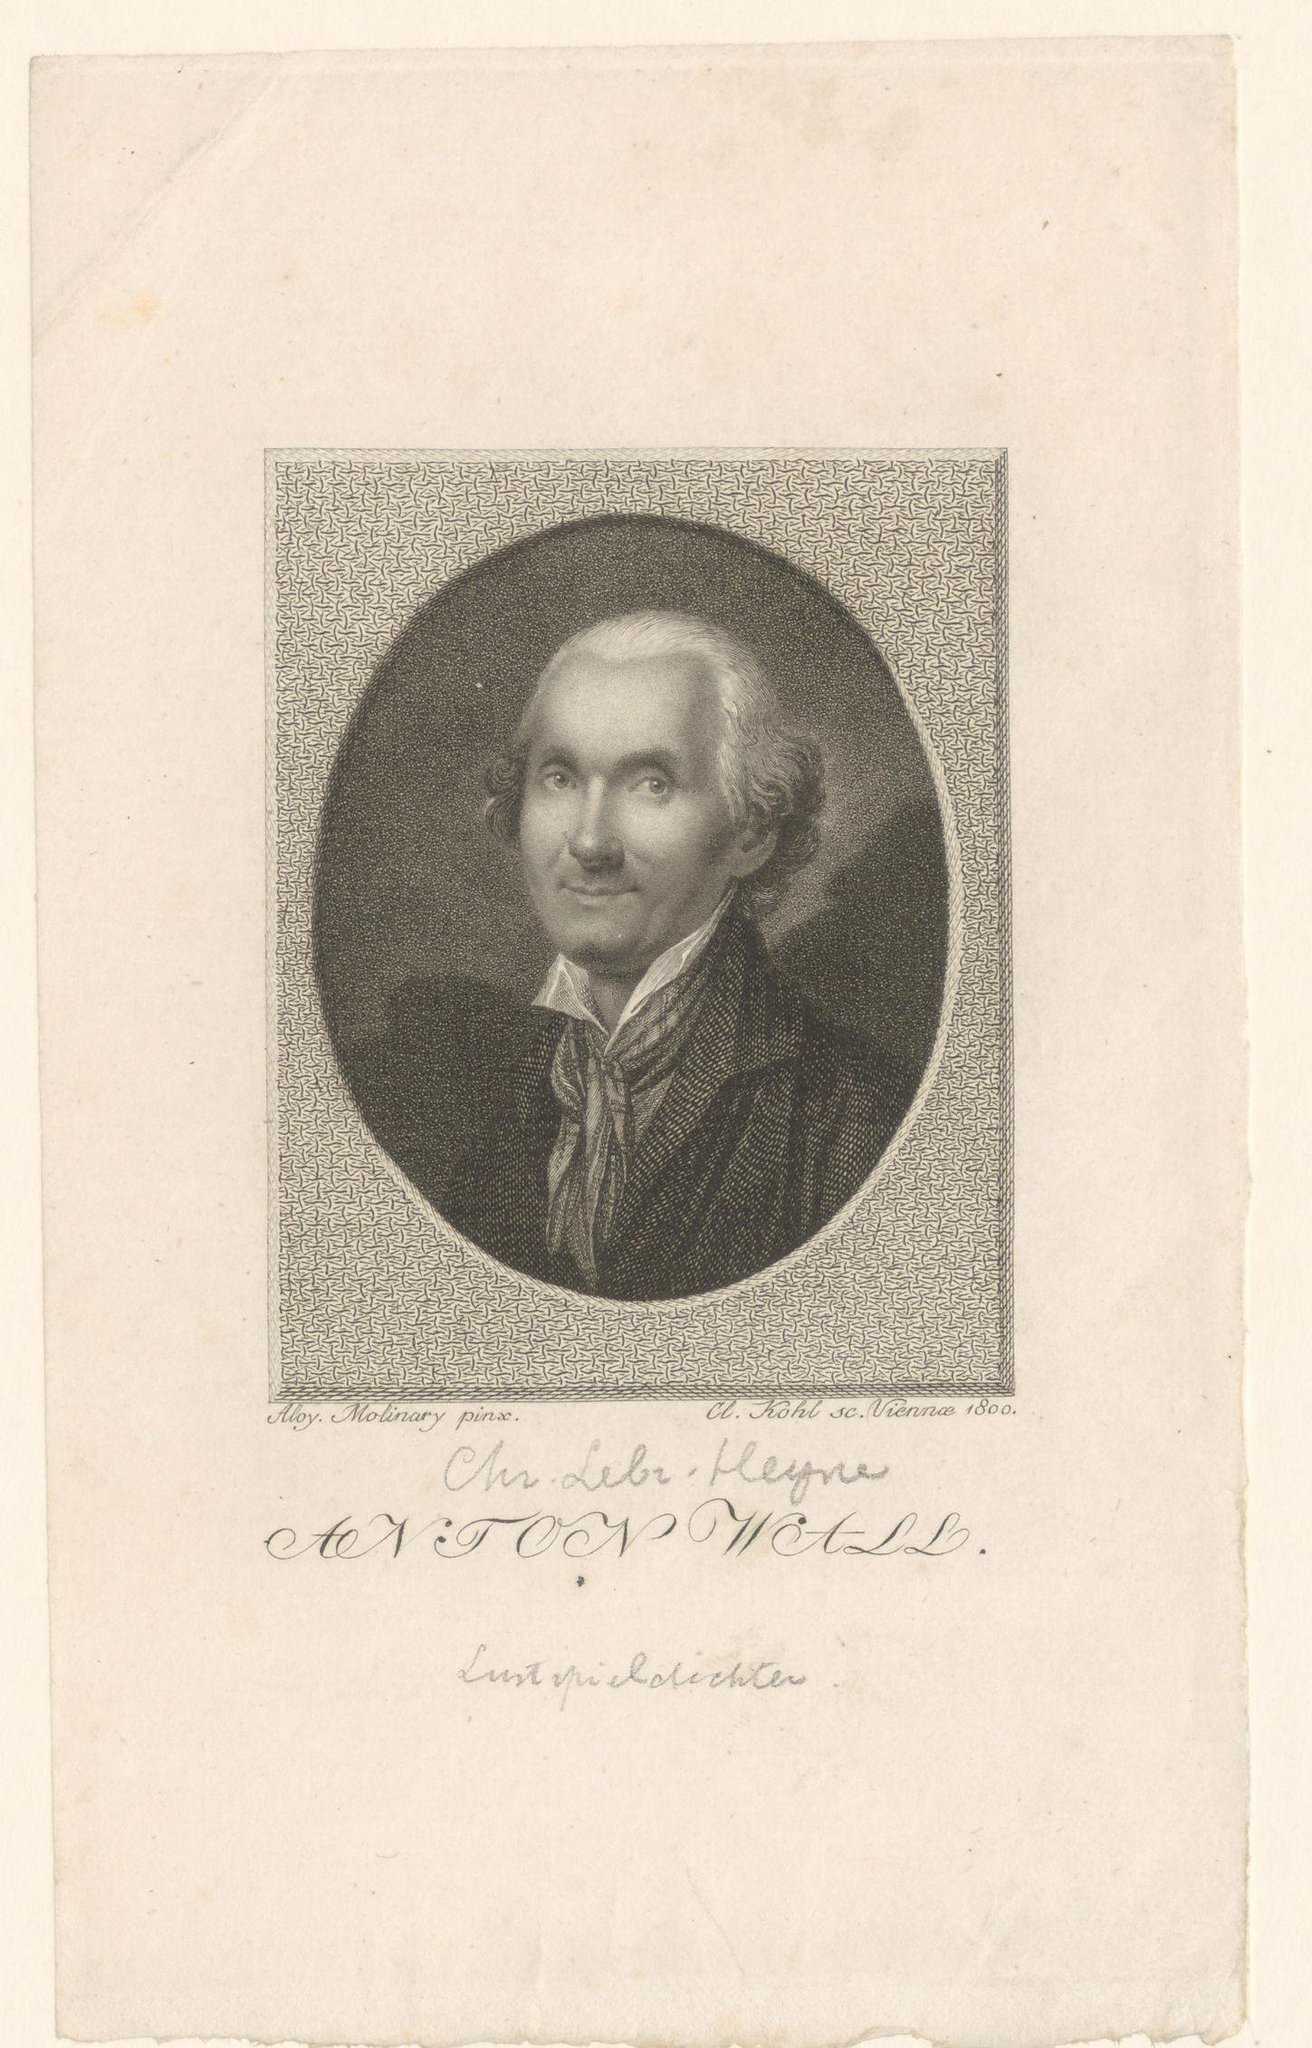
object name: print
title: Portret van Christian Leberecht Heyne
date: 1800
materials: paper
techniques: engraving, etching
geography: vienna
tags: historical persons, lawyer, attorney at law, portrait of a writer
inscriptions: collector's mark: Lugt 2228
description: Geportretteerde ook bekend onder het pseudoniem Anton Wall.